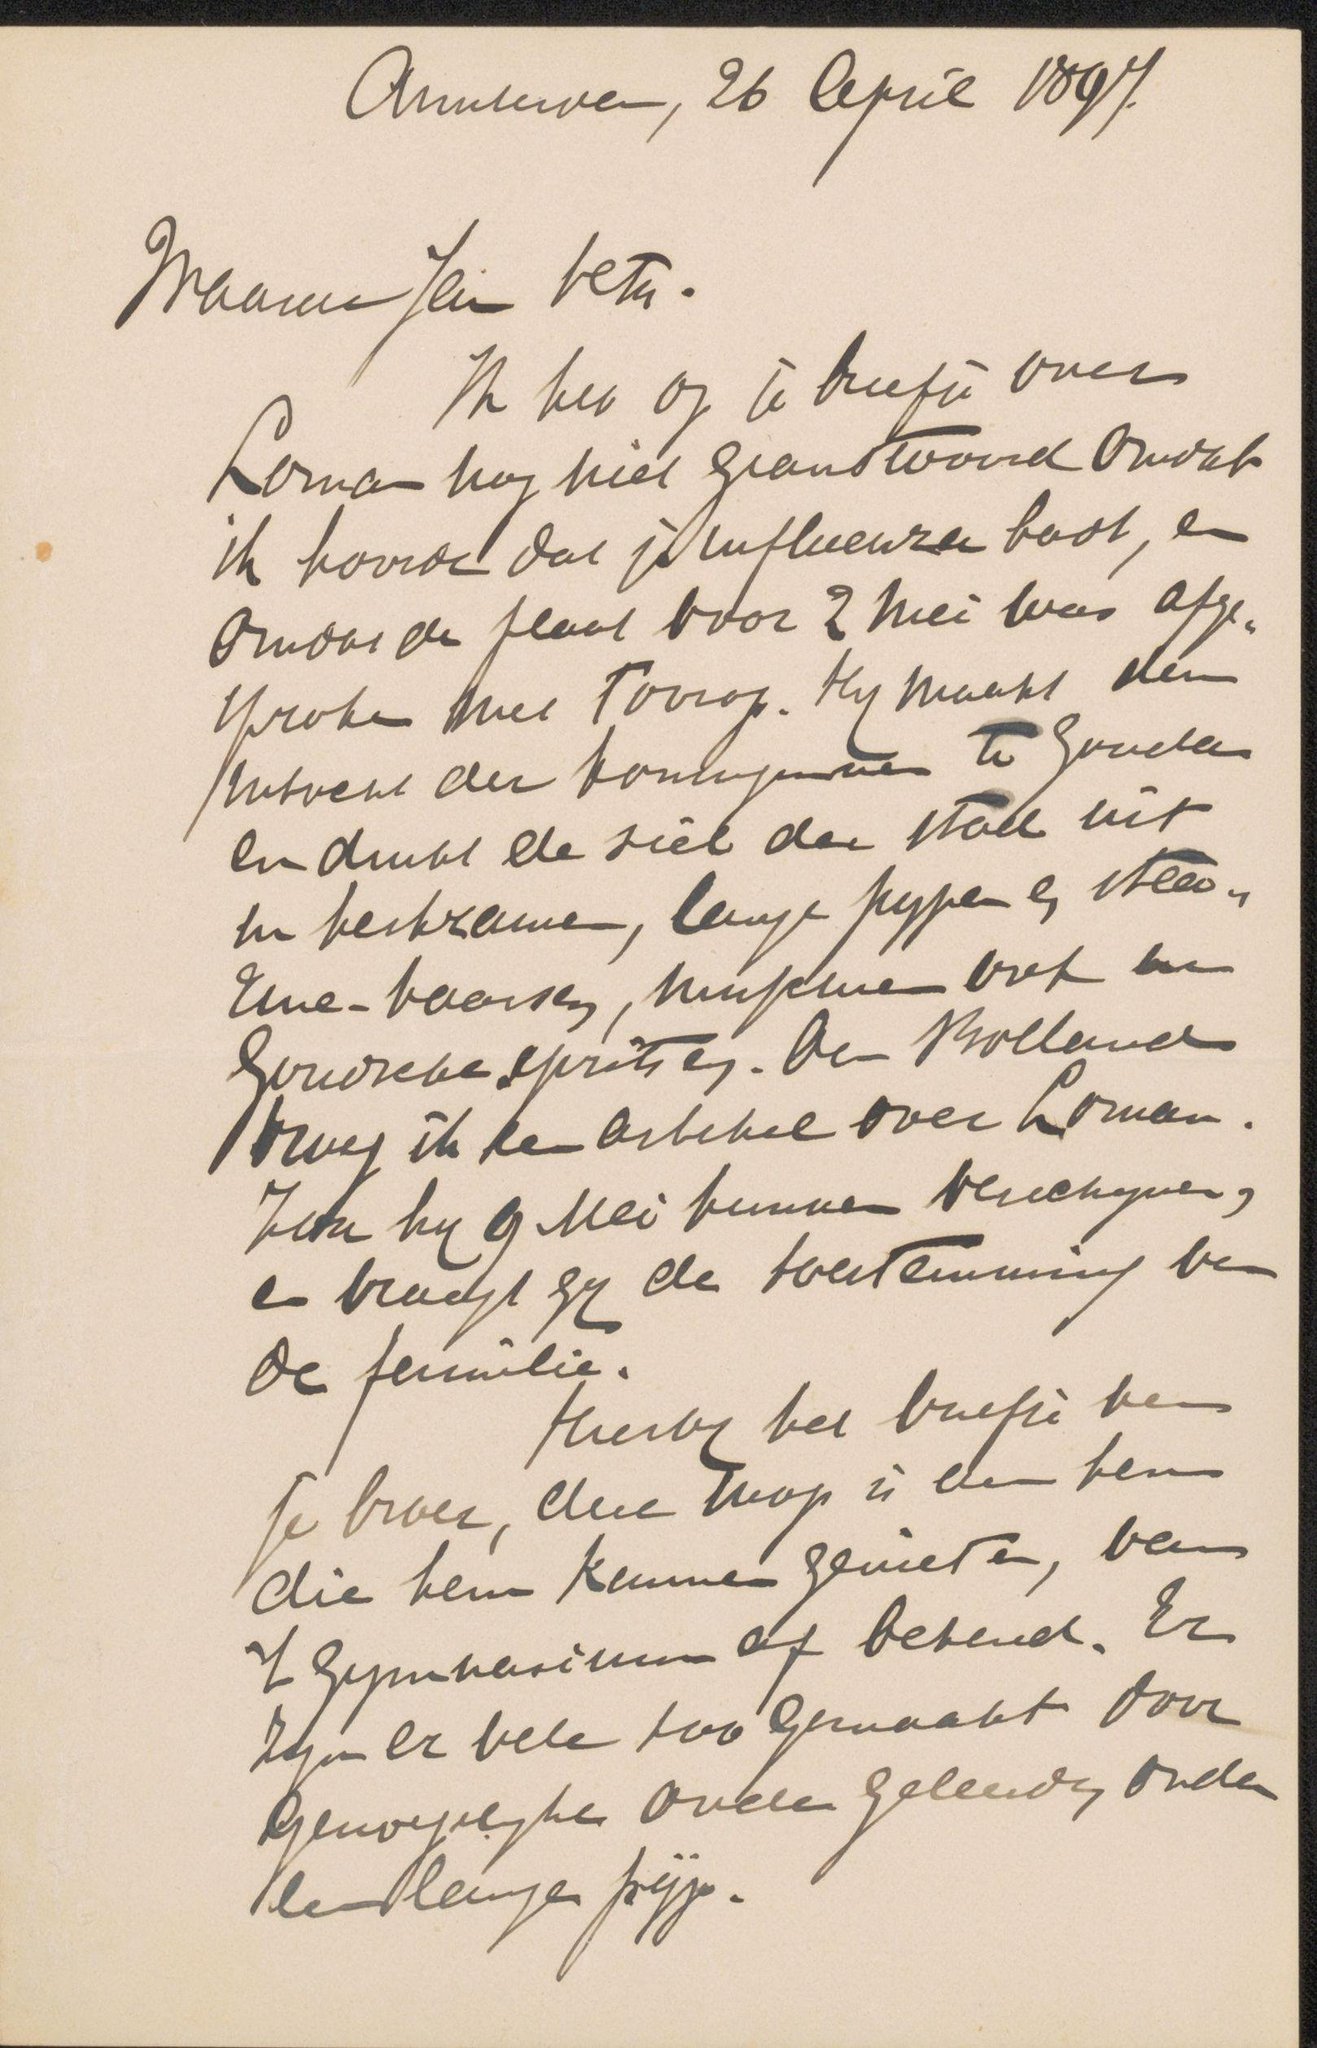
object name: letter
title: Brief aan Jan Veth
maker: pieter lodewijk tak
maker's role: politician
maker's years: 1848-1907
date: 1897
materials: ink, paper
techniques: pen, writing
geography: amsterdam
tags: dordrecht, painter, print maker, draughtsman, designer, jan veth, jan toorop, cornelis gerardus 't hooft, diseases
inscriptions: collector's mark: ‘RPK’